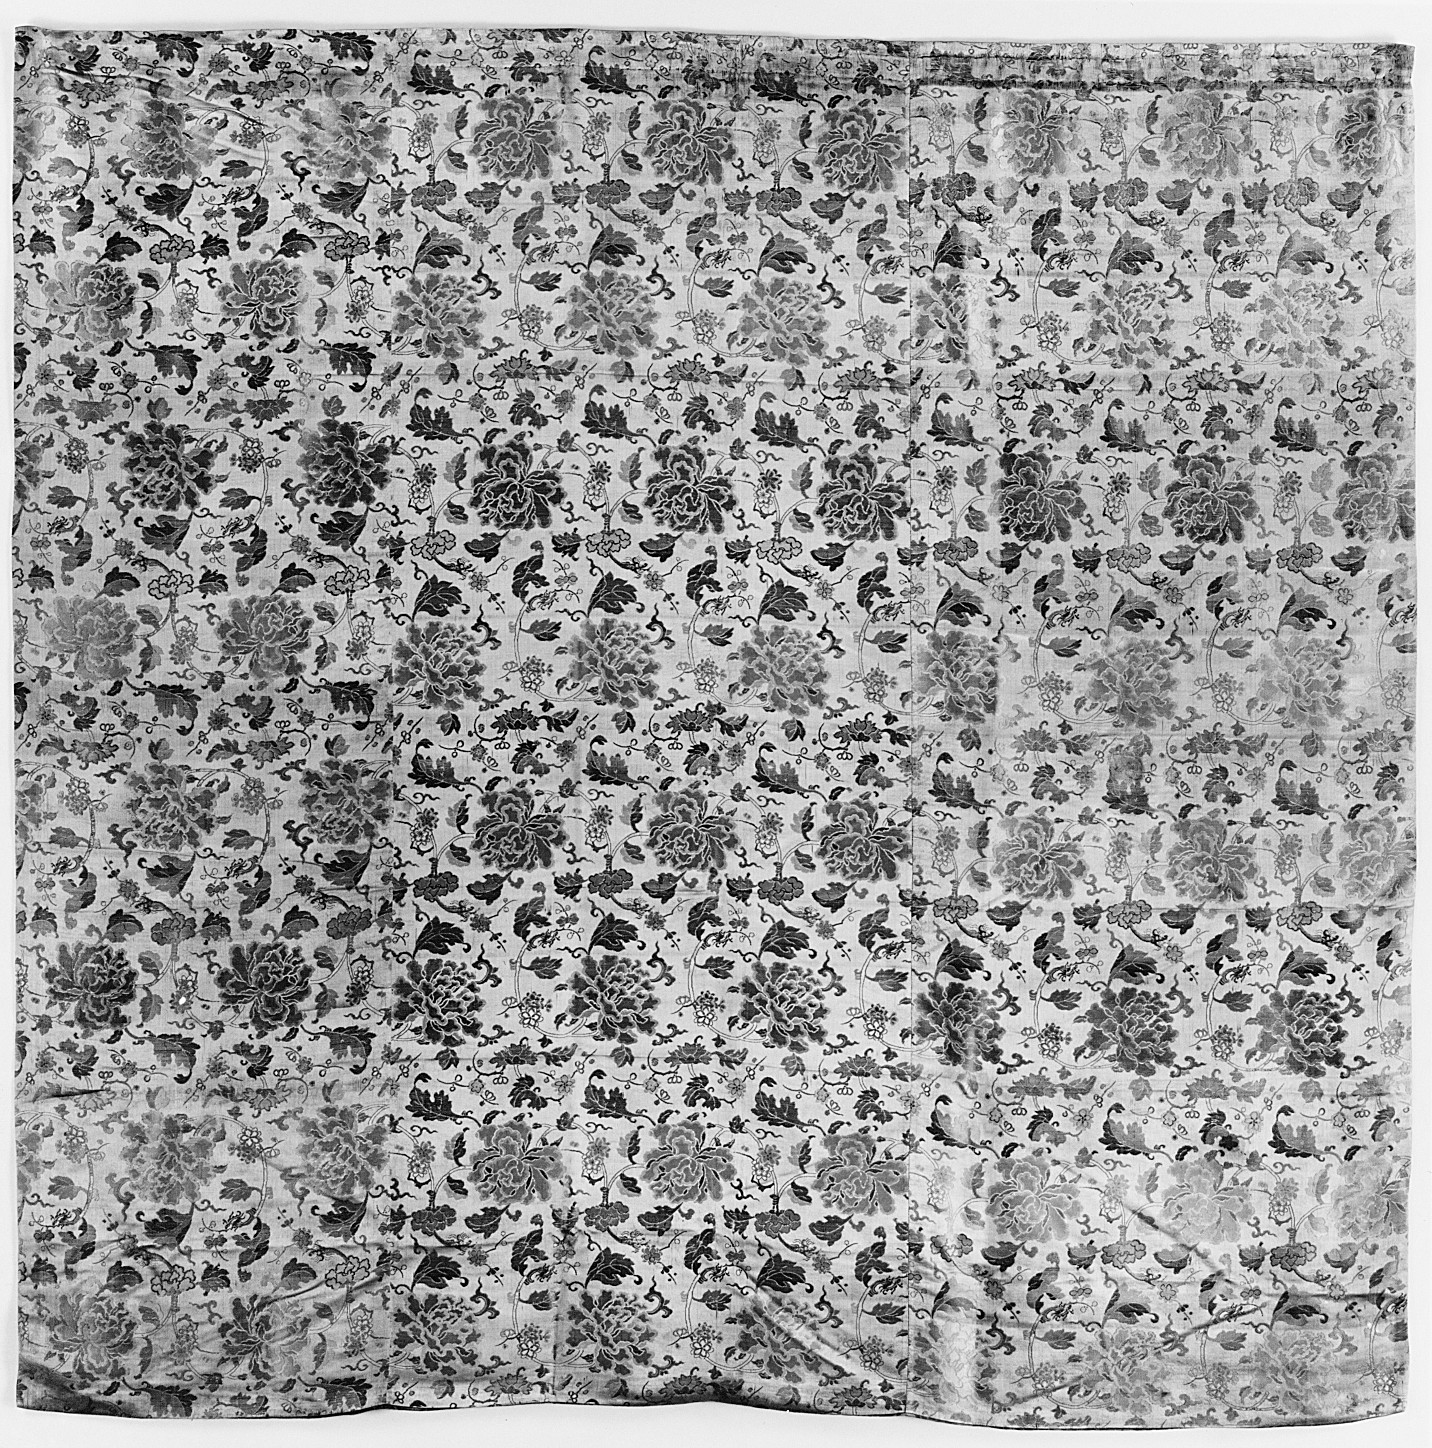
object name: panel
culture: chinese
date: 1720-1750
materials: silk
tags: flowers,leaves